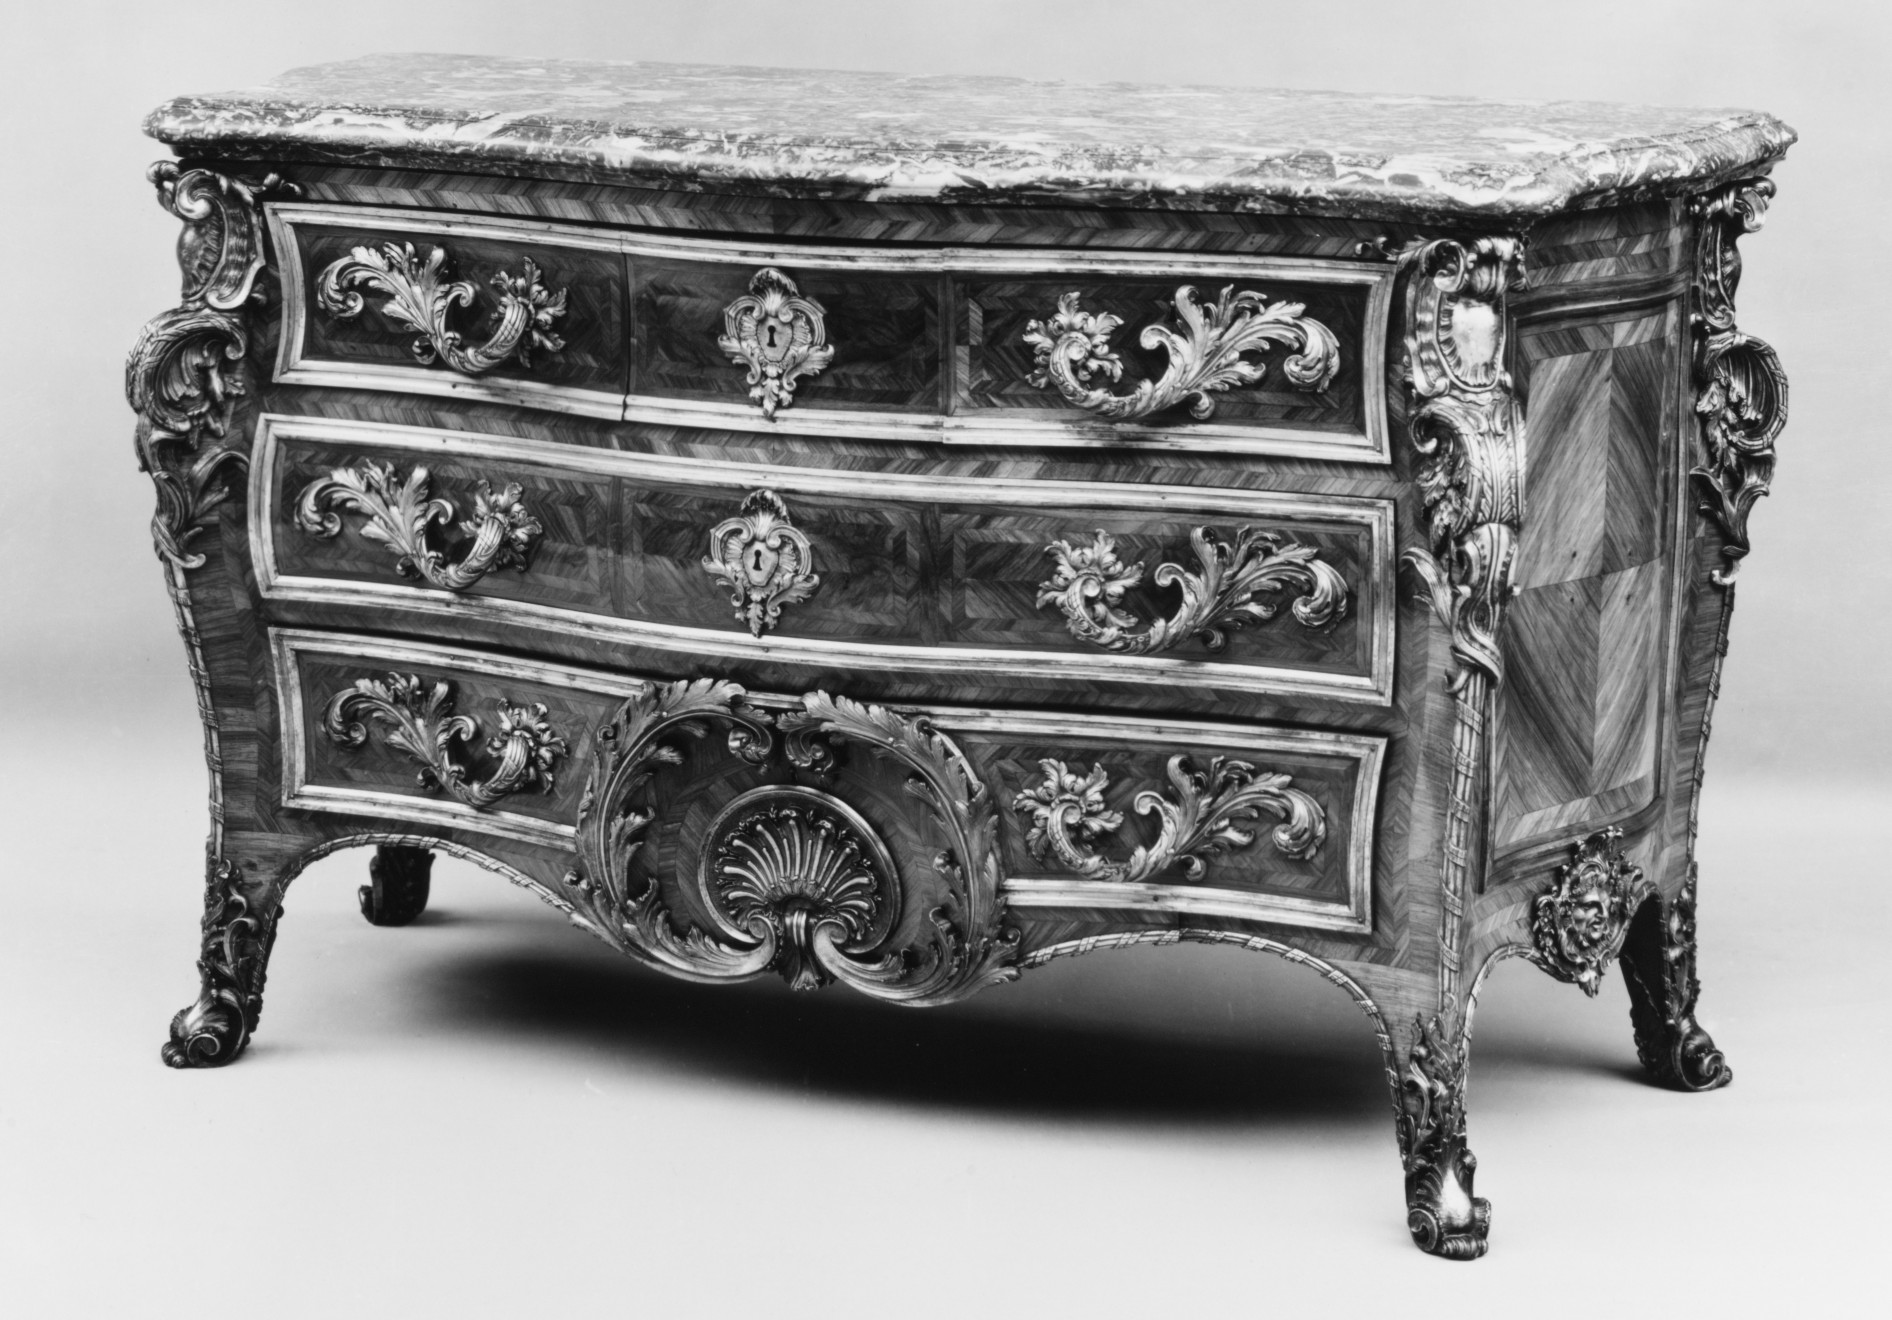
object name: commode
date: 1735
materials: gilt bronze, marble, wood